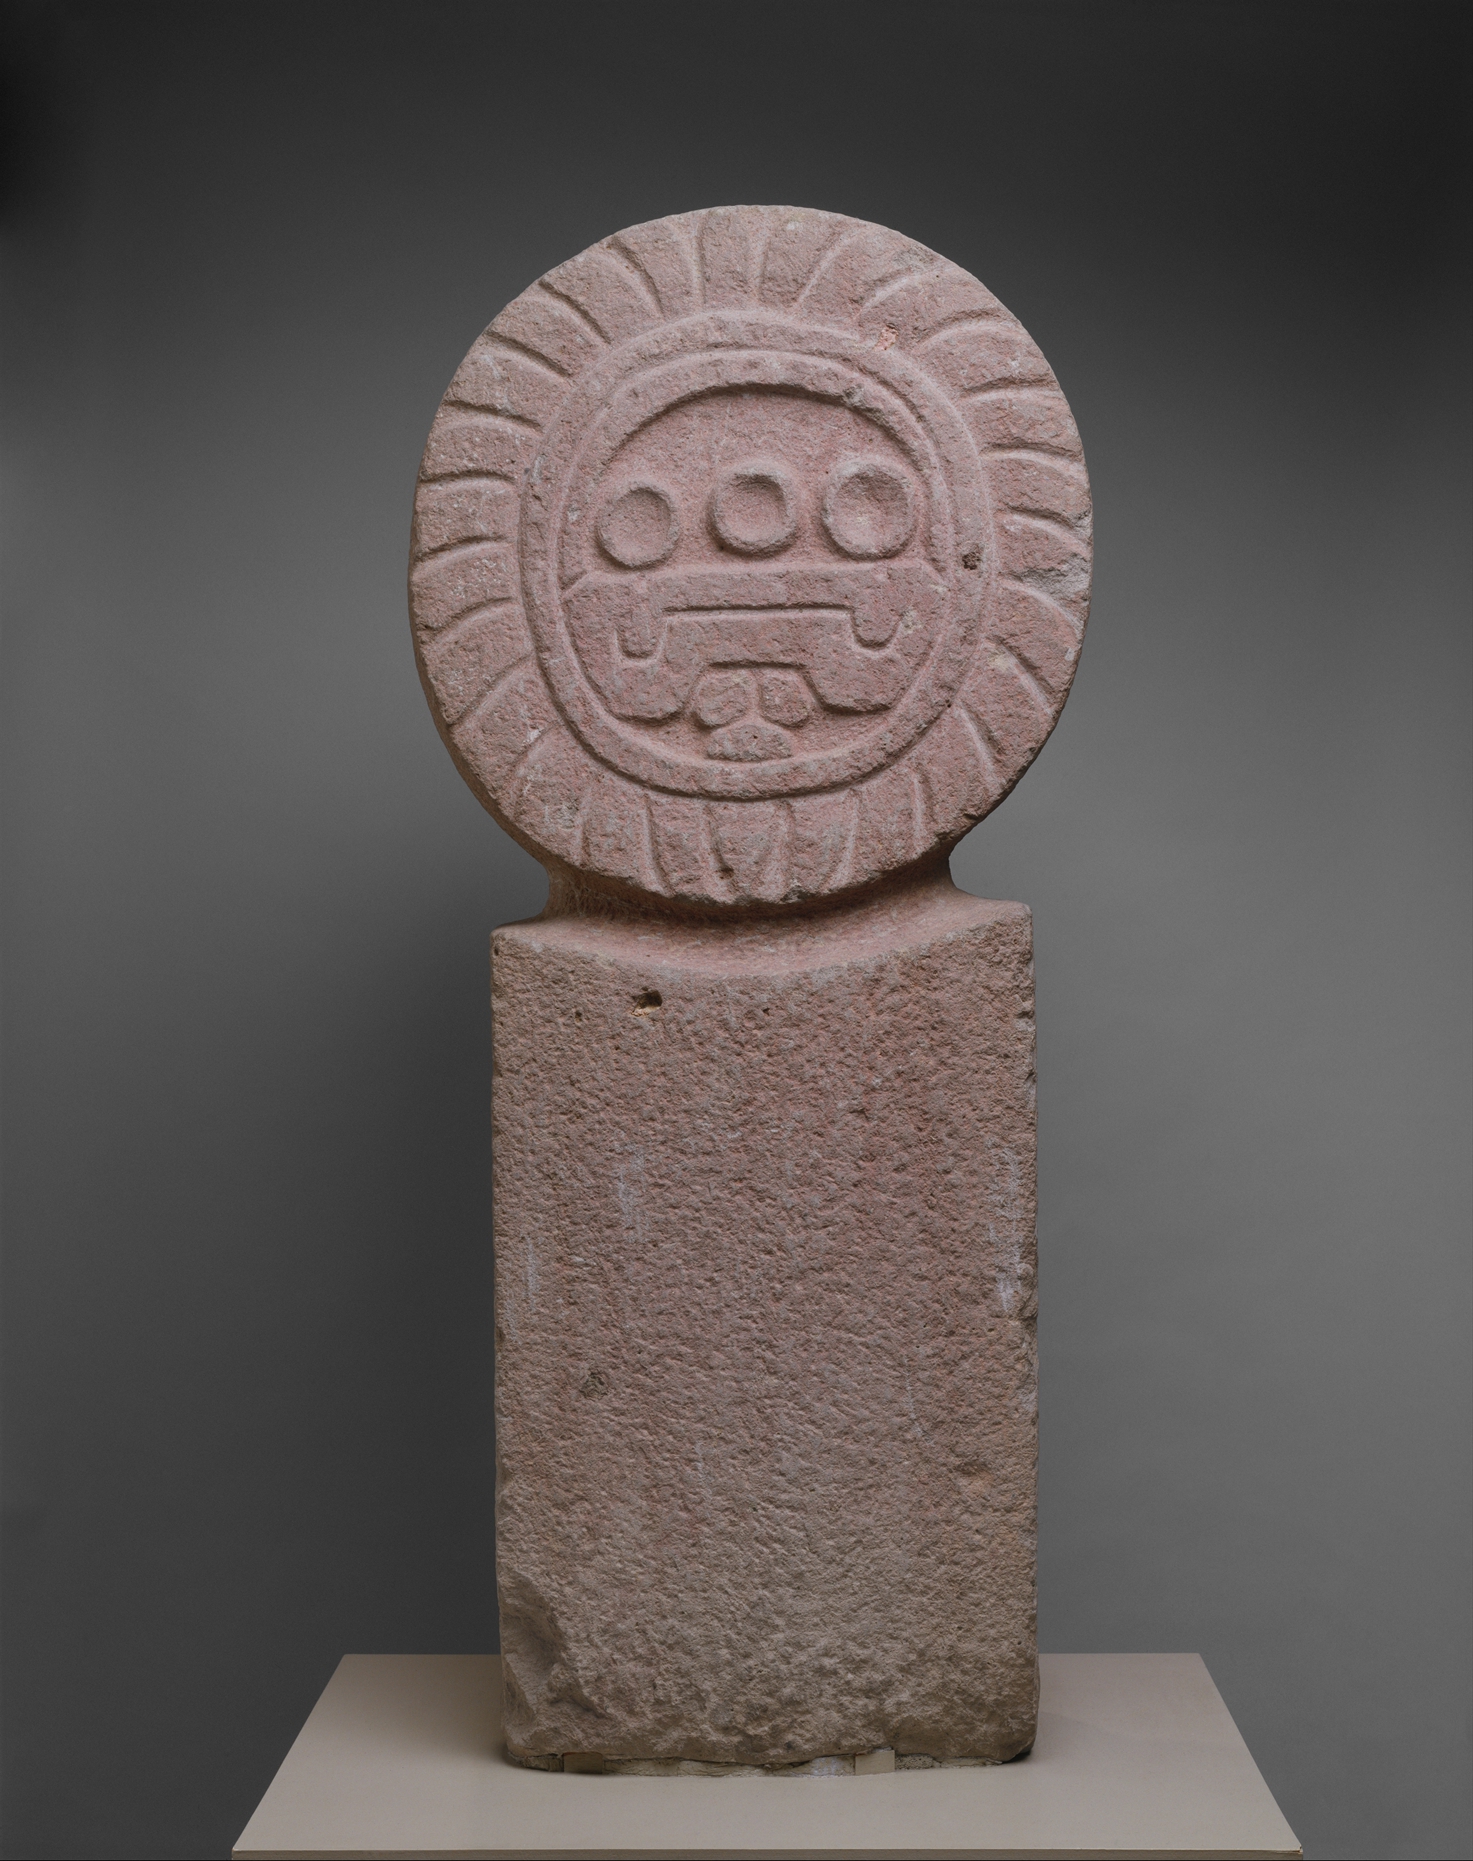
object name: stela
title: Stone marker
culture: teotihuacan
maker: teotihuacan artist(s)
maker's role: artist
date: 350-450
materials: pigment, stone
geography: mexico